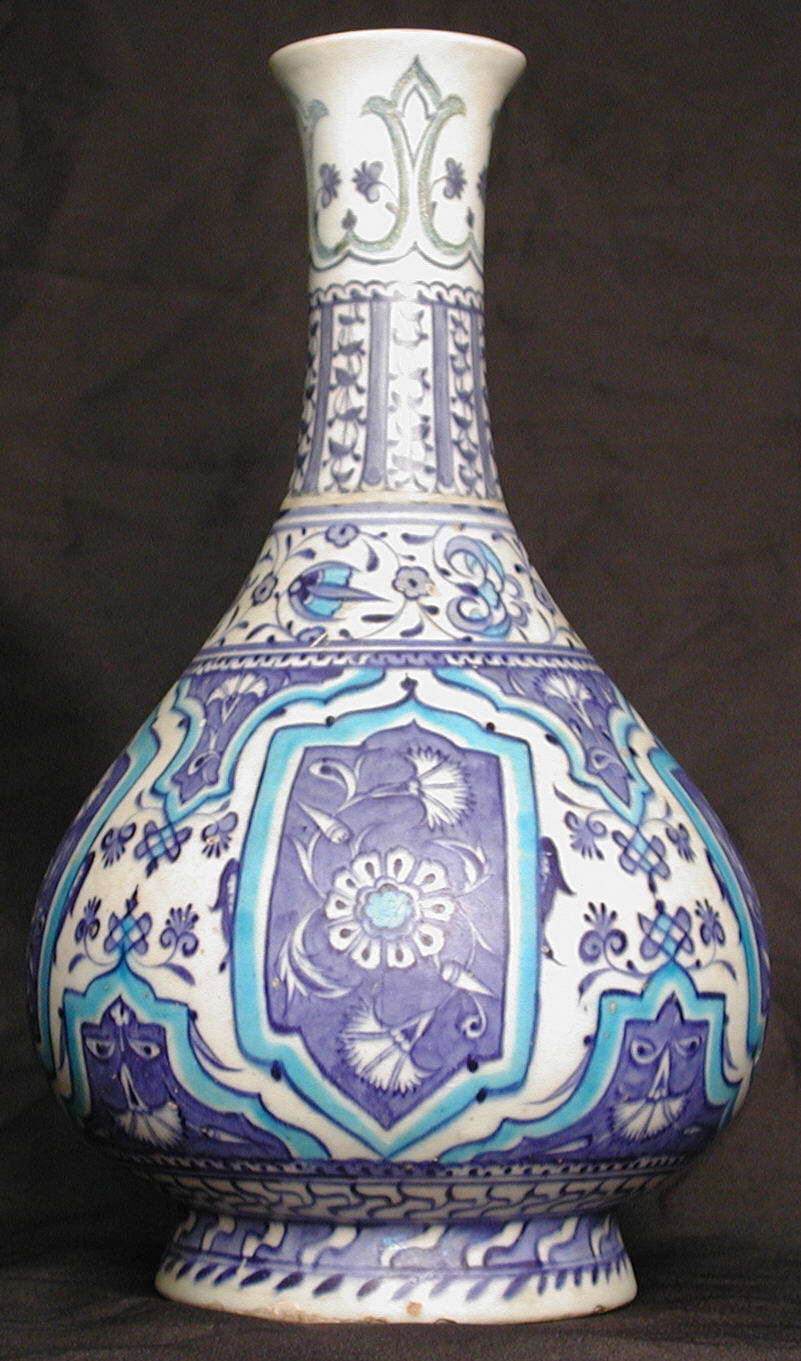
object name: bottle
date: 1526-1550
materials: stonepaste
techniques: painting, underglaze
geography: turkey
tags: flowers